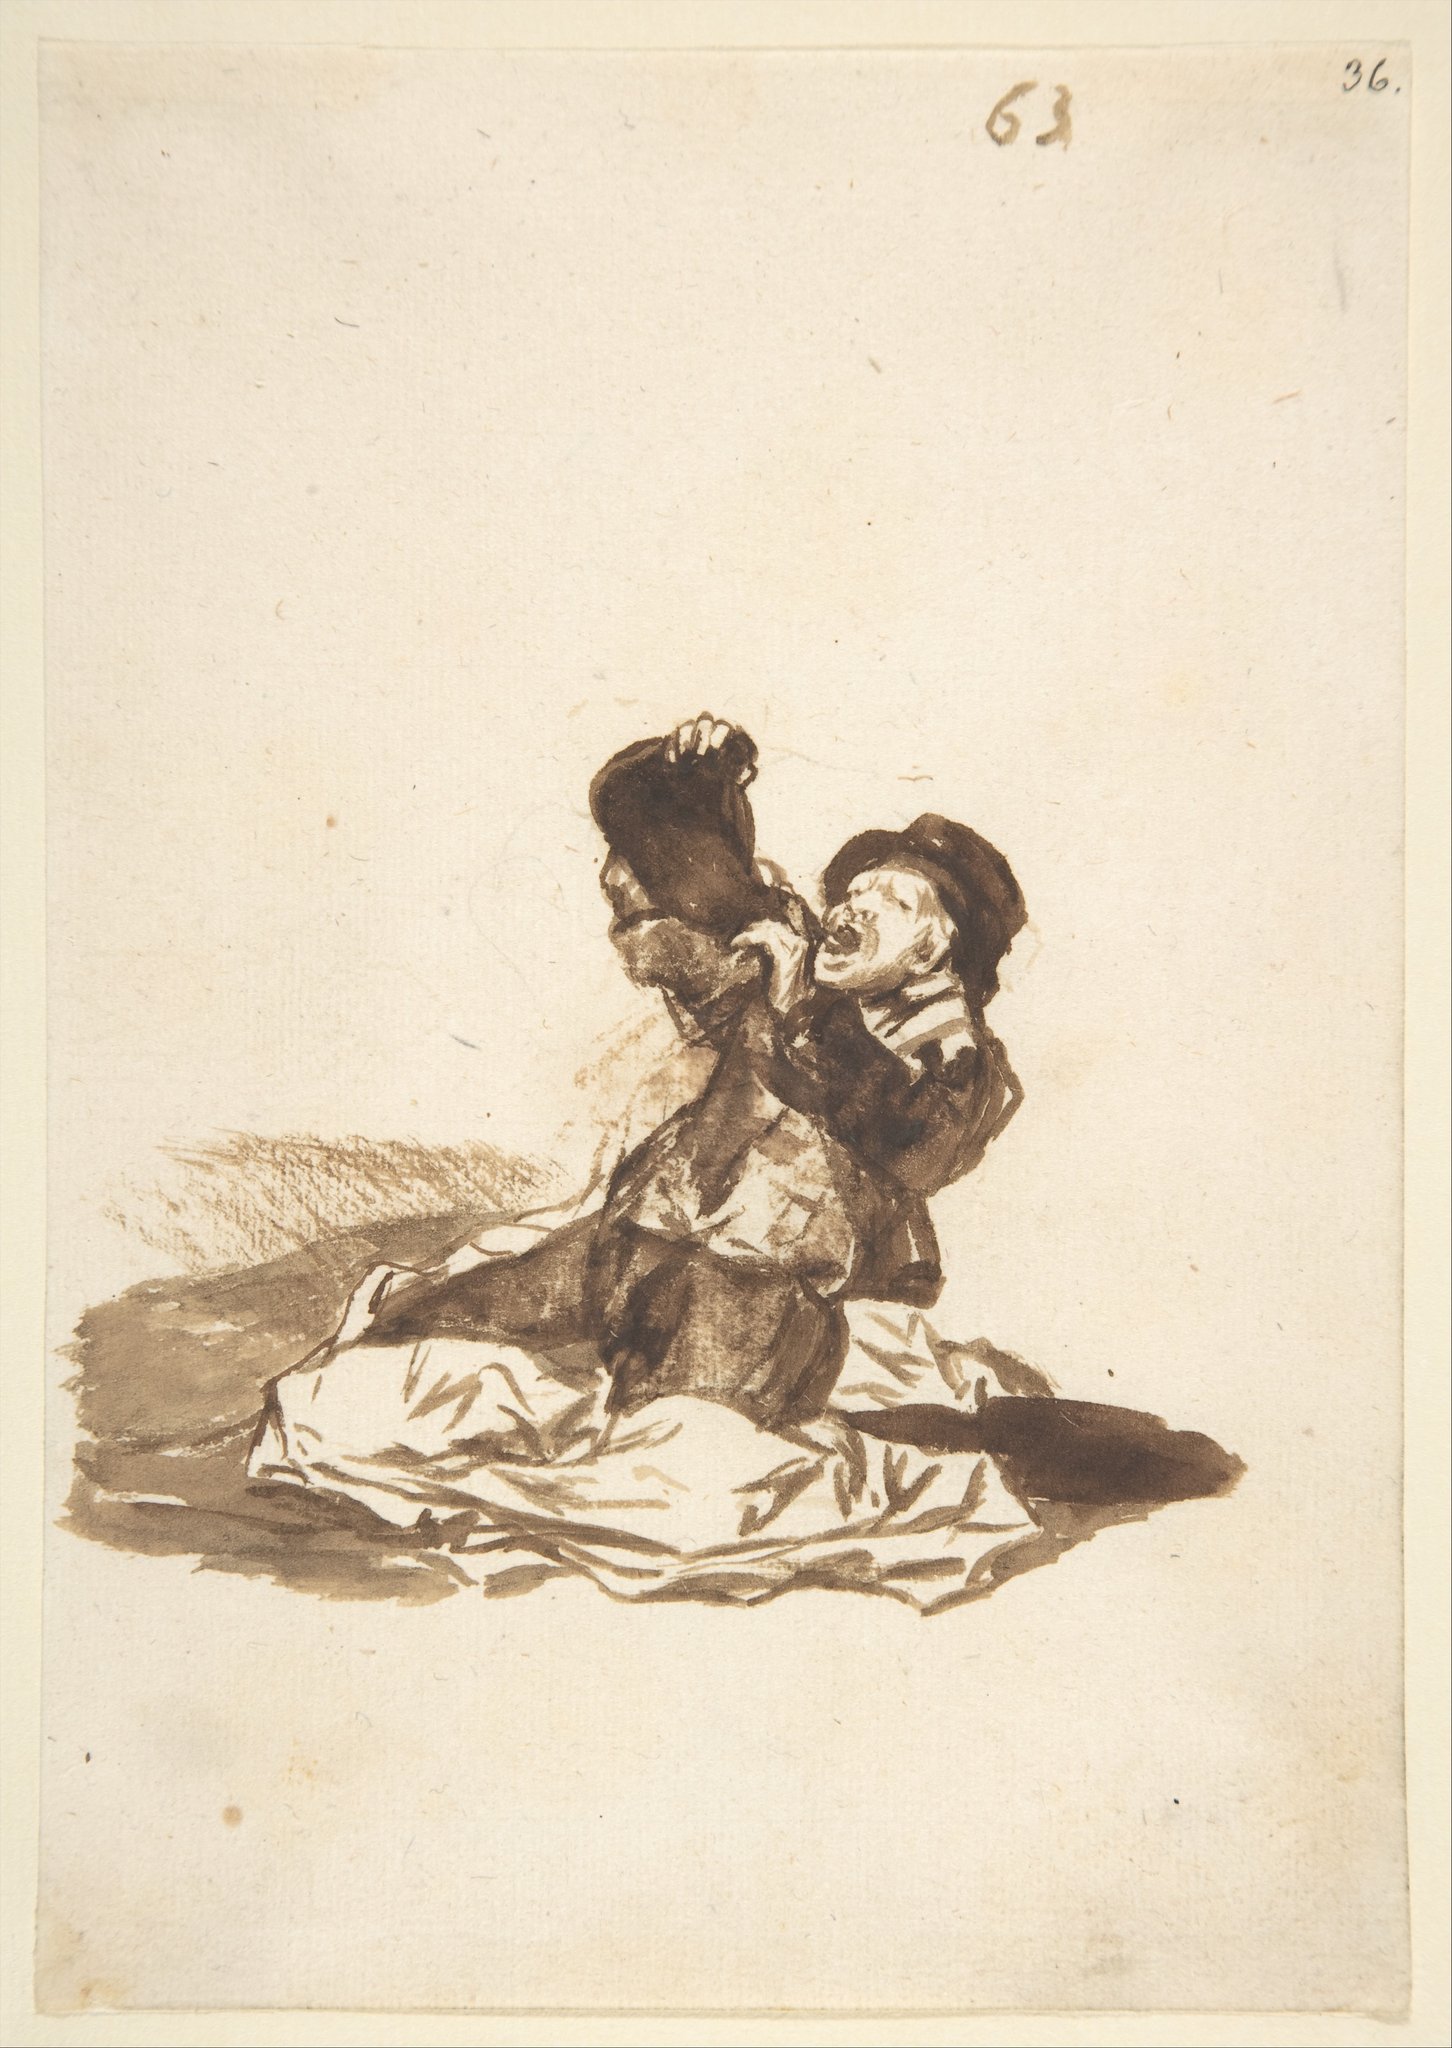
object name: drawing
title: A man on the ground drinking from a wine skin; folio 63 from the "Images of Spain" Album (F)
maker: goya (francisco de goya y lucientes)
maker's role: artist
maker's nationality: spanish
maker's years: 1746-1828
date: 1812-1820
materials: chalk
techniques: brush, wash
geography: spain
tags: men,drinking